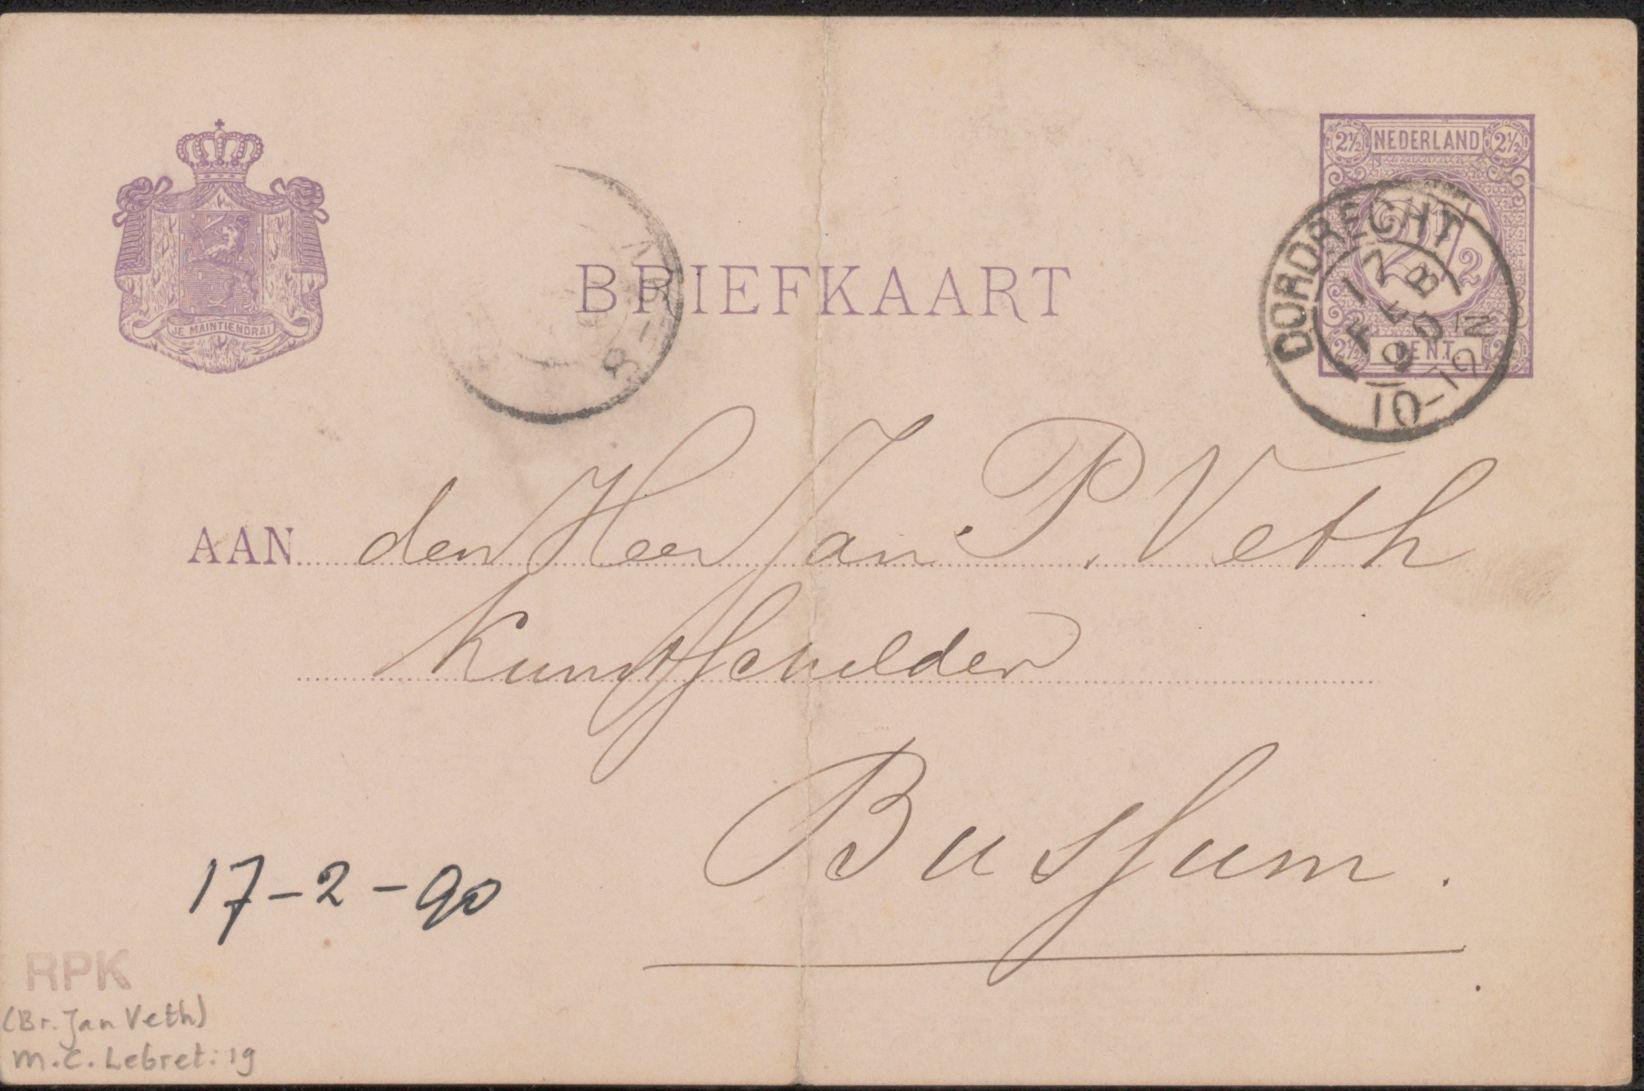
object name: postcard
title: Briefkaart aan Jan Veth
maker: martinus cornelis lebret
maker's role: verzamelaar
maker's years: 1833-1894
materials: cardboard, ink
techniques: pen, writing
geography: dordrecht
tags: dordrecht, print maker, draughtsman, designer, jan veth, jacob maris, isaac israels, the hague, painter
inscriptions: collector's mark: ‘RPK’